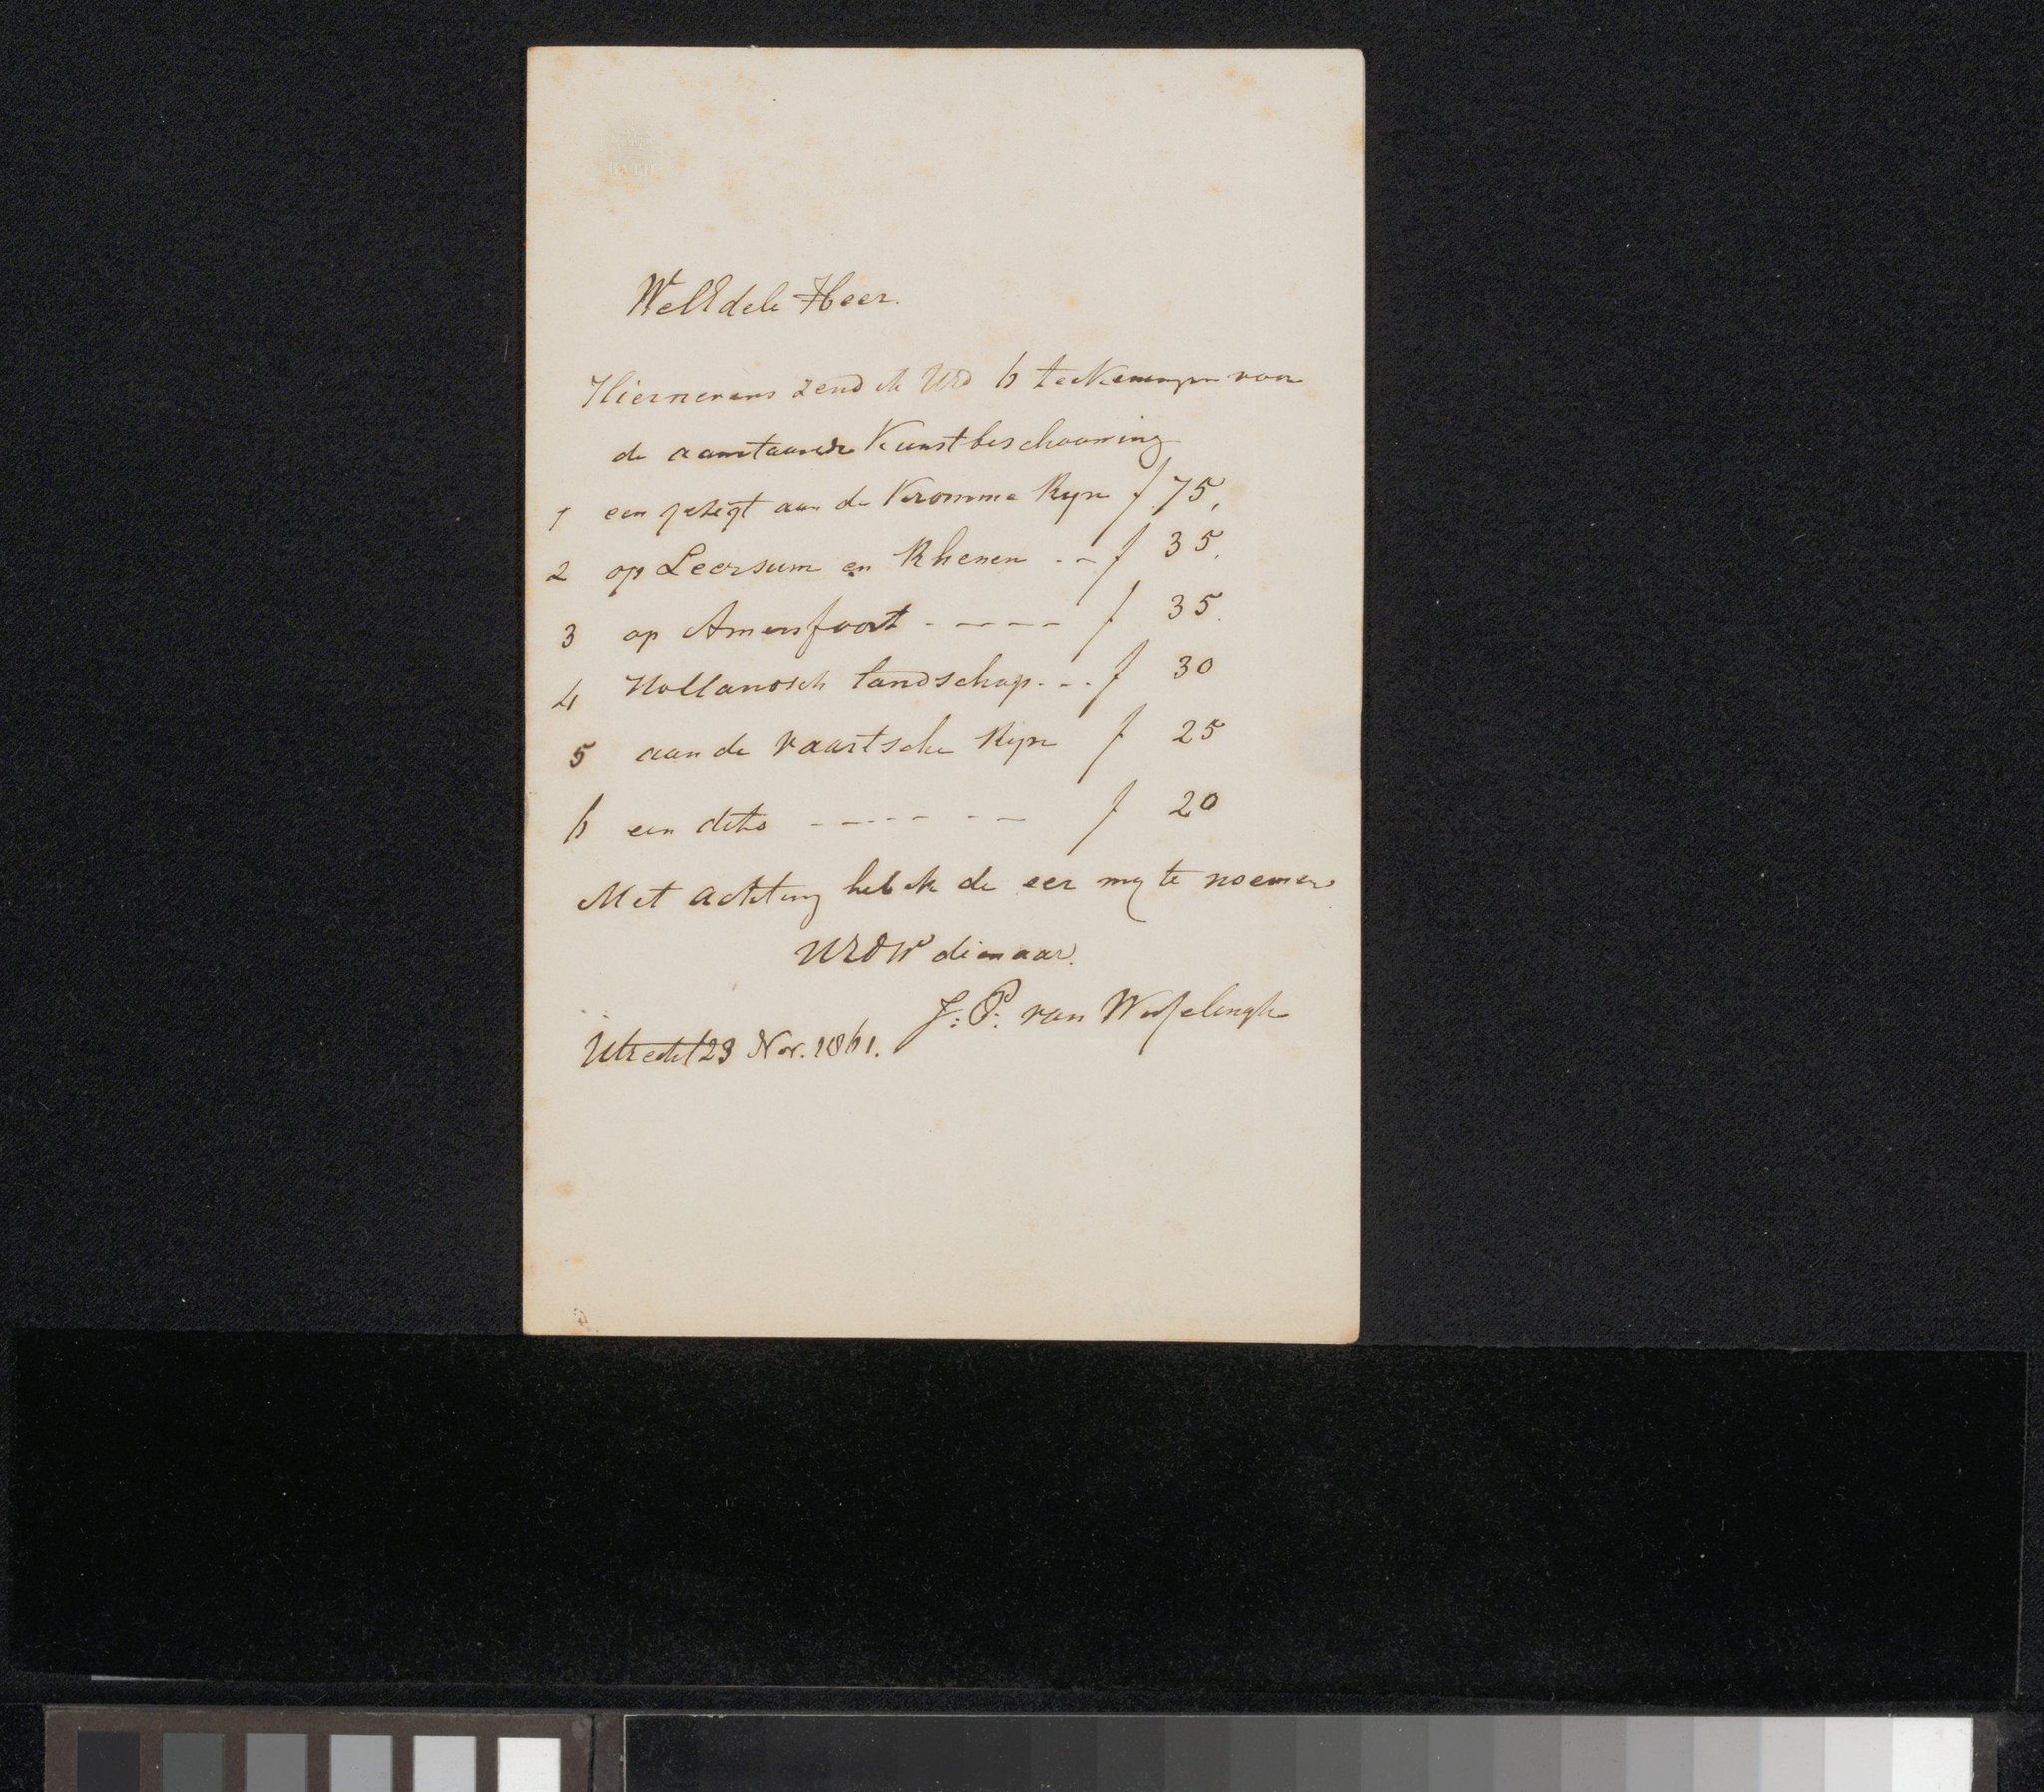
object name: letter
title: Brief aan Pieter Verloren van Themaat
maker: johannes pieter van wisselingh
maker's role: draughtsman, painter, print maker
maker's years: 1812-1899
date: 1861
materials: ink, paper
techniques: pen, writing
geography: utrecht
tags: utrecht, pieter verloren van themaat, criticizing and discussing art, art criticism, drawing, money